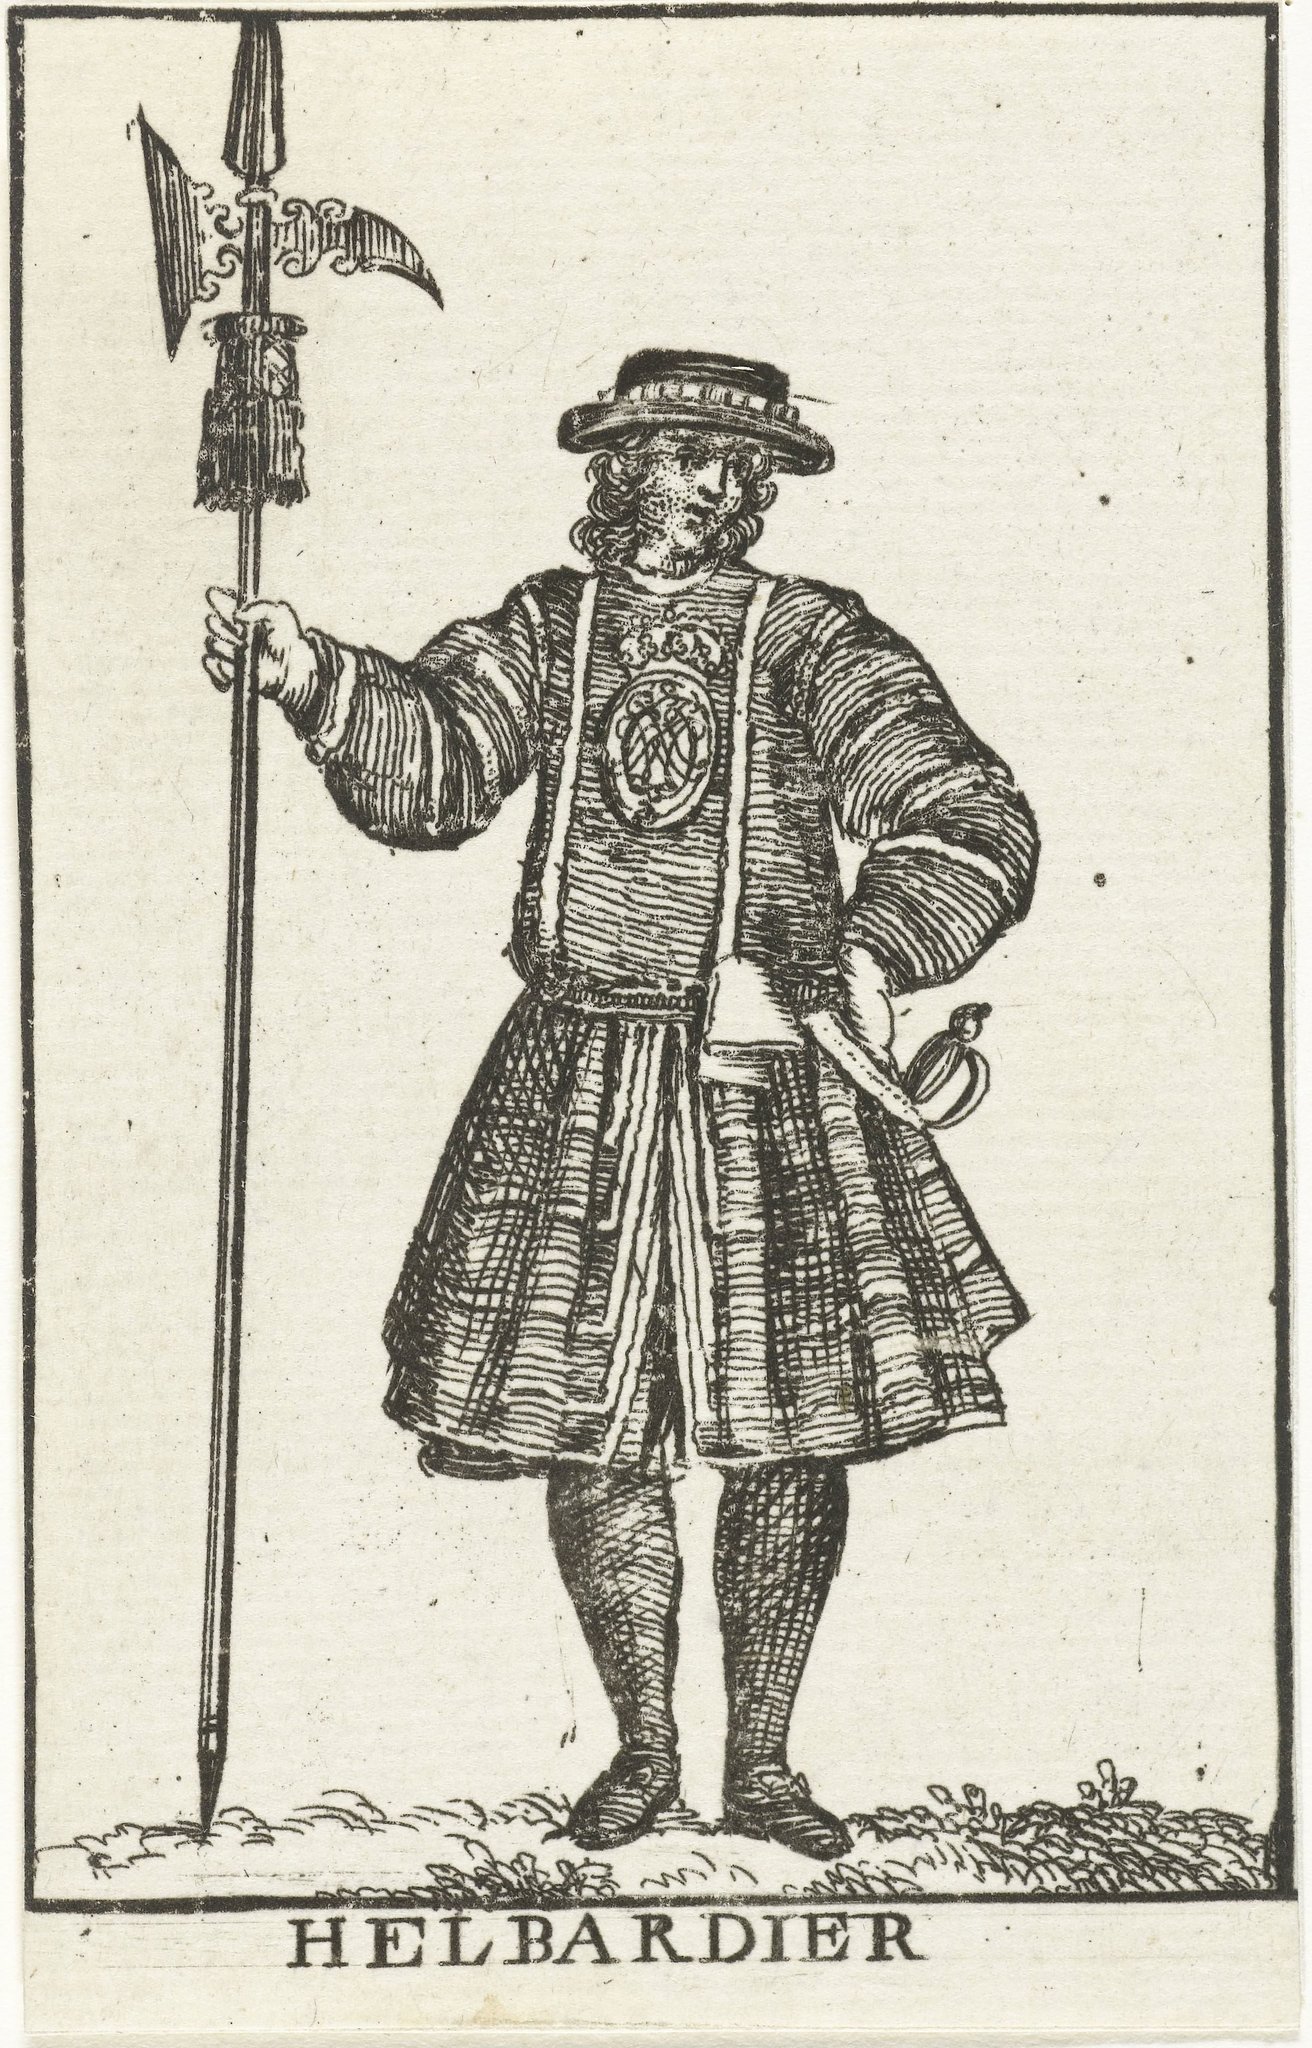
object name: print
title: Helbardier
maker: Anonymous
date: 1740-1760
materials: paper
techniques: etching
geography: northern netherlands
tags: land forces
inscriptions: collector's mark: Lugt 2228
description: Een hellebardier in een tuniek met een geborduurd embleem op de borst en een hellebaard in zijn rechter hand, ca. 1750.